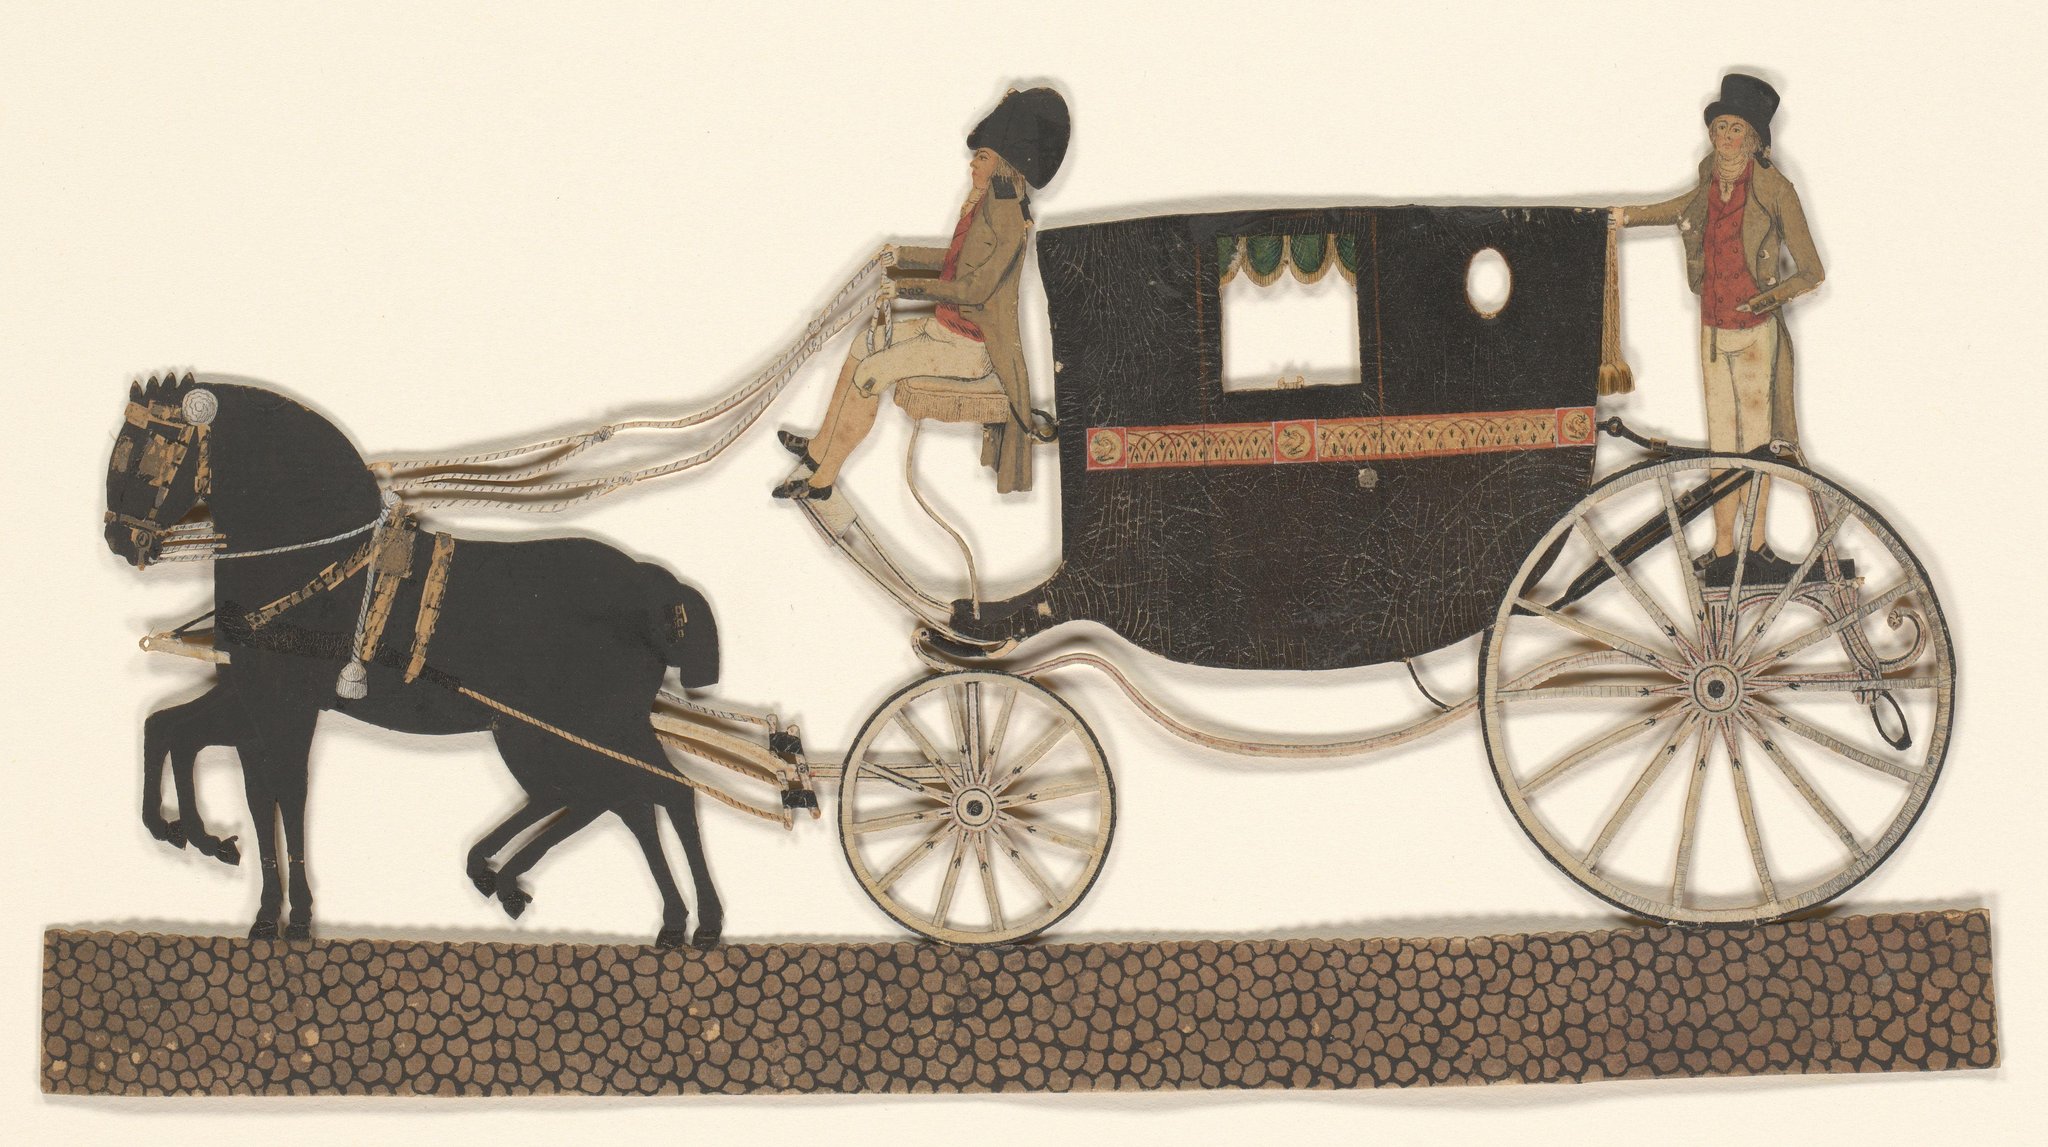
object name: clipping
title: Knipsel van dicht rijtuig met koetsier en palfrenier, bespannen met twee paarden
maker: Anonymous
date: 1750-1850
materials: cardboard, paint, paper, watercolor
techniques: brush, pen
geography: netherlands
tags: four-wheeled vehicle drawn by two animals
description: Knipsel van een dicht rijtuig op vier wielen, met koetsier en palfrenier, bespannen met twee paarden. Knipsel van beschilderd karton.